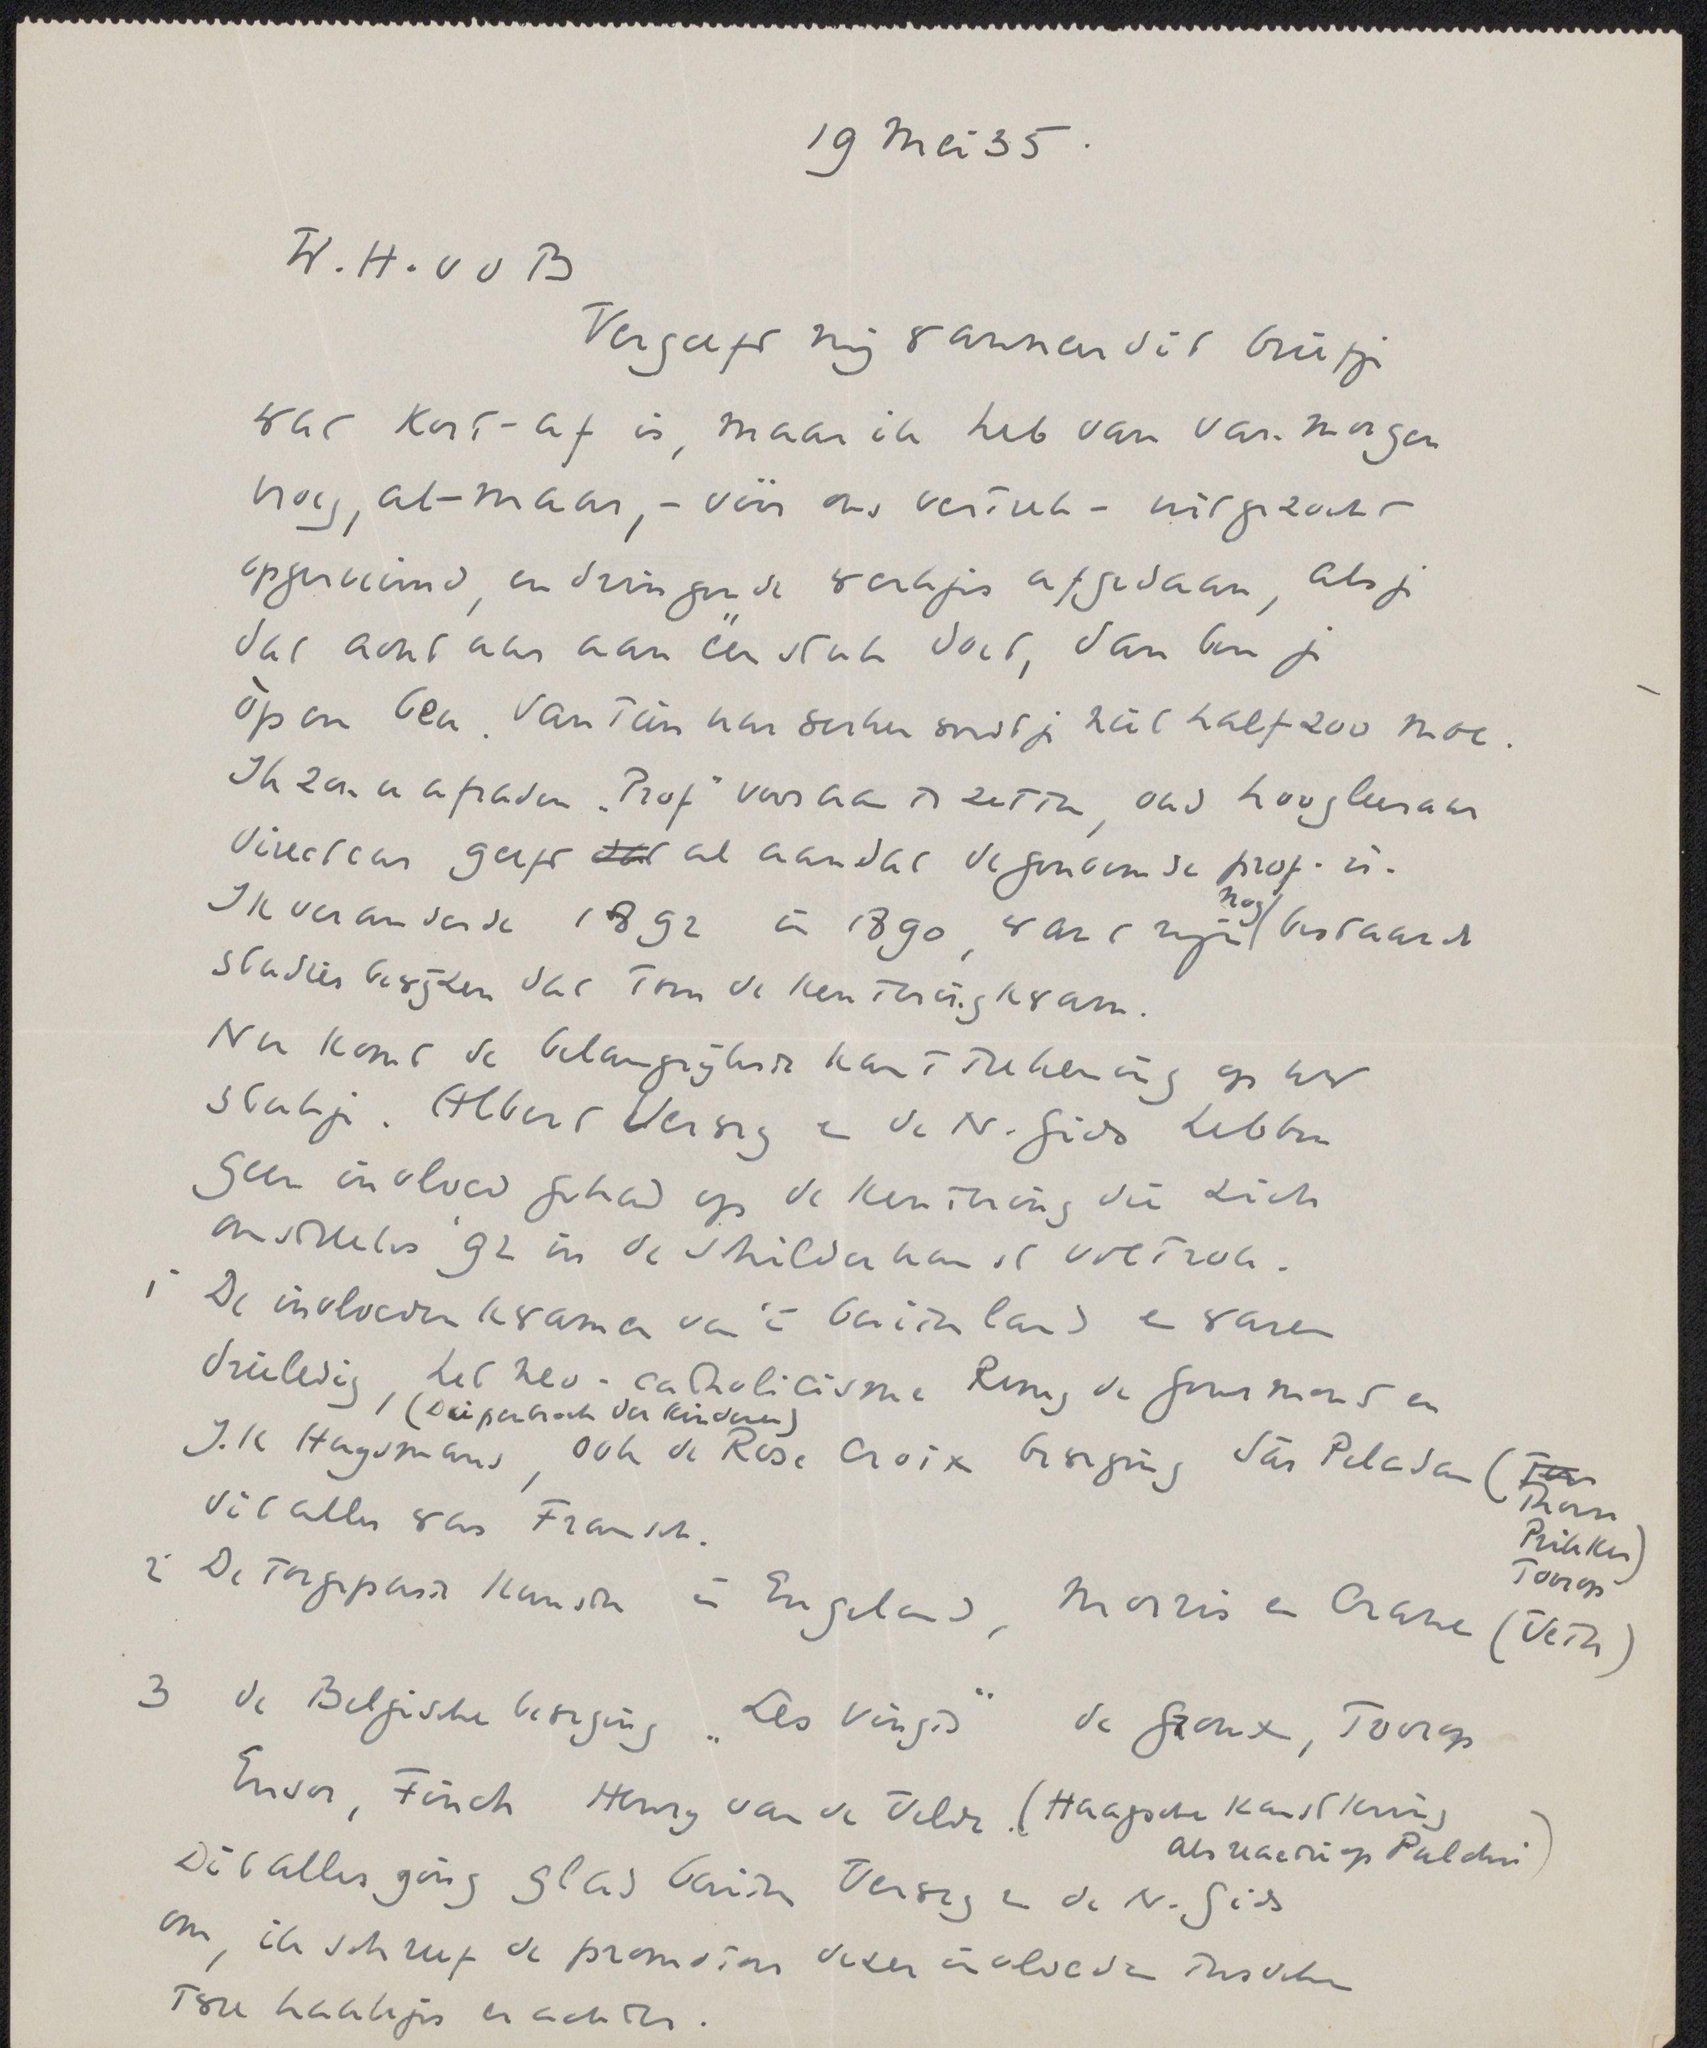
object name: letter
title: Brief aan A. van der Boom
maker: richard nicolaüs roland holst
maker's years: 1868-1938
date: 1935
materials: ink, paper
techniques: pen, writing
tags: a. van der boom, brussels, print maker, alfred william finch, rotterdam, amsterdam, painter, draughtsman, george hendrik breitner, dordrecht, designer, jan veth, den bosch, antoon derkinderen, james ensor, johan thorn prikker, jan toorop, william morris, liverpool, walter crane, albert verwey, alphons diepenbrock, education, tuition of the artist (in general)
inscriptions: collector's mark: Lugt L.2228a